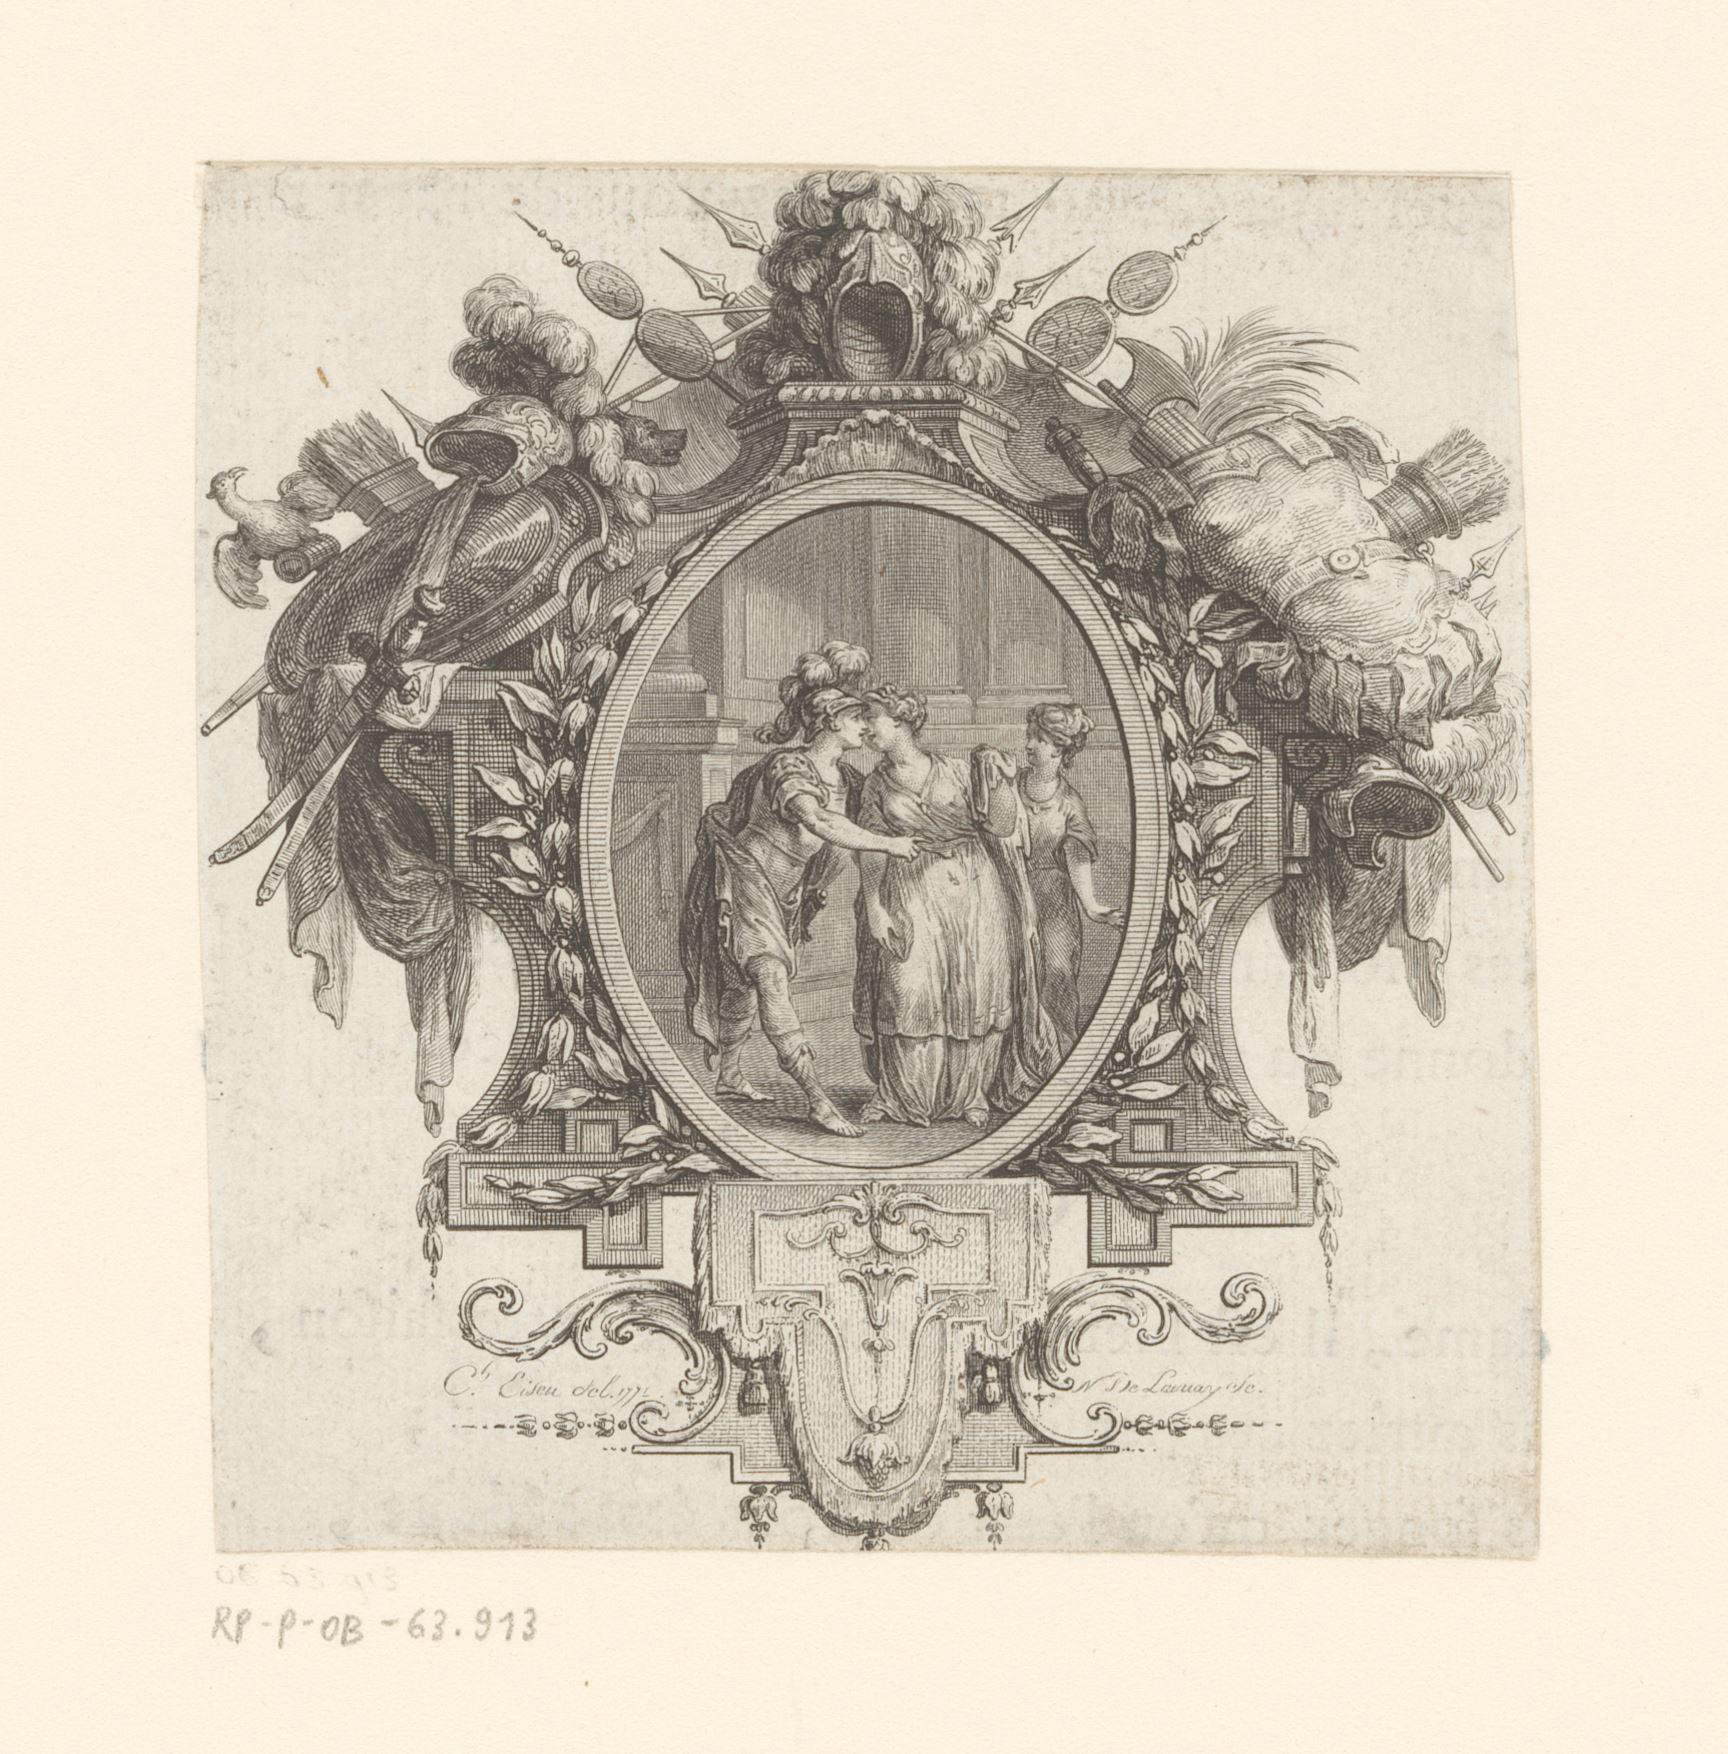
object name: print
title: Vignet met soldaat die vrouw begroet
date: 1771-1792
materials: paper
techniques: engraving, etching, letterpress printing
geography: france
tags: embracing each other, kissing, soldiers and civilians